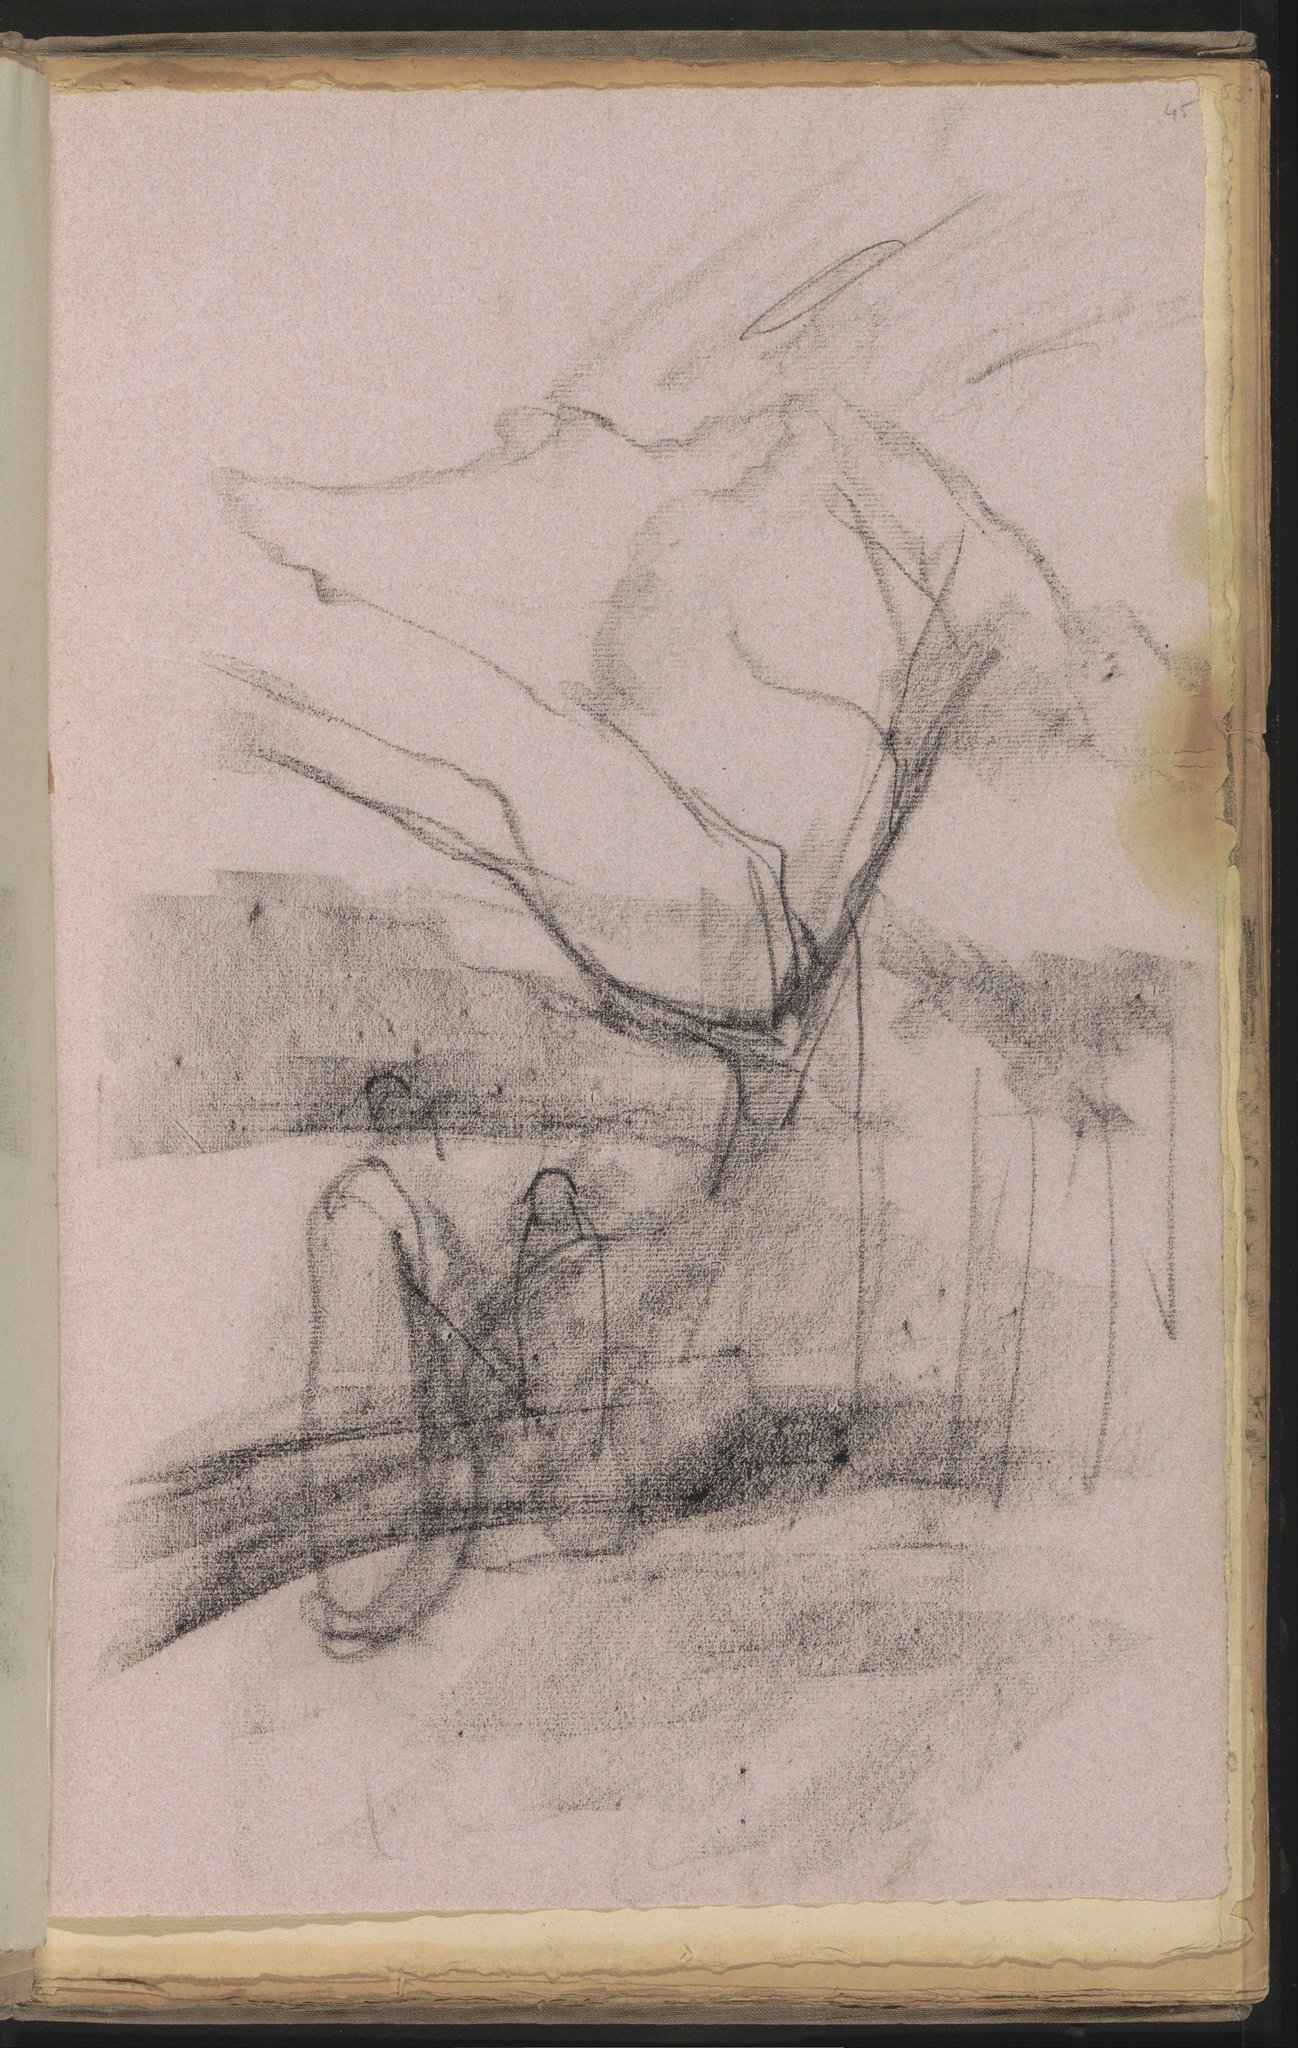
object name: sketchbook leaf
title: Twee figuren in een landschap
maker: willem witsen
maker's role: draughtsman, painter, print maker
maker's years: 1860-1923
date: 1884-1887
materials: chalk, paper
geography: ewijkshoeve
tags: landscapes in the temperate zone (+ landscape with figures, staffage)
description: Pagina 45 uit een schetsboek met 42 bladen vervaardigd rond de Ewijkshoeve.